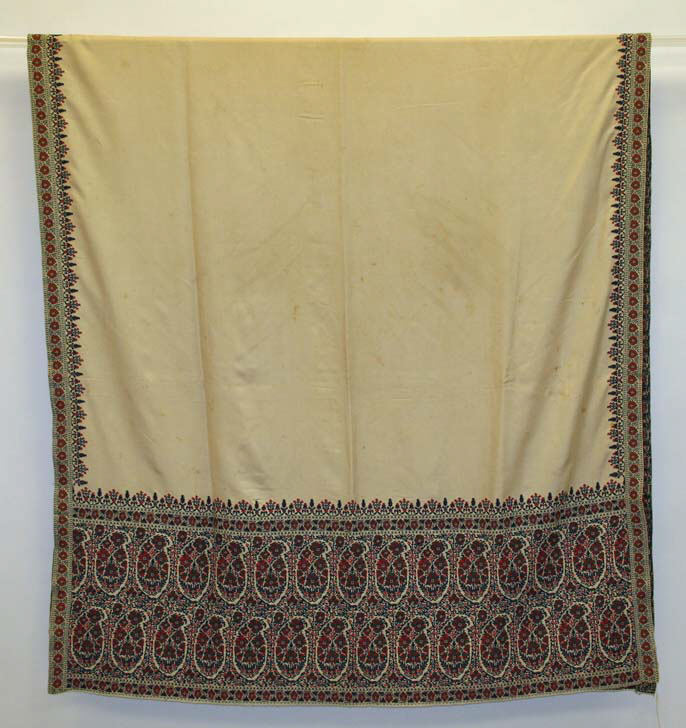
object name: shawl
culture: indian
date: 1800-1810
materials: silk, wool